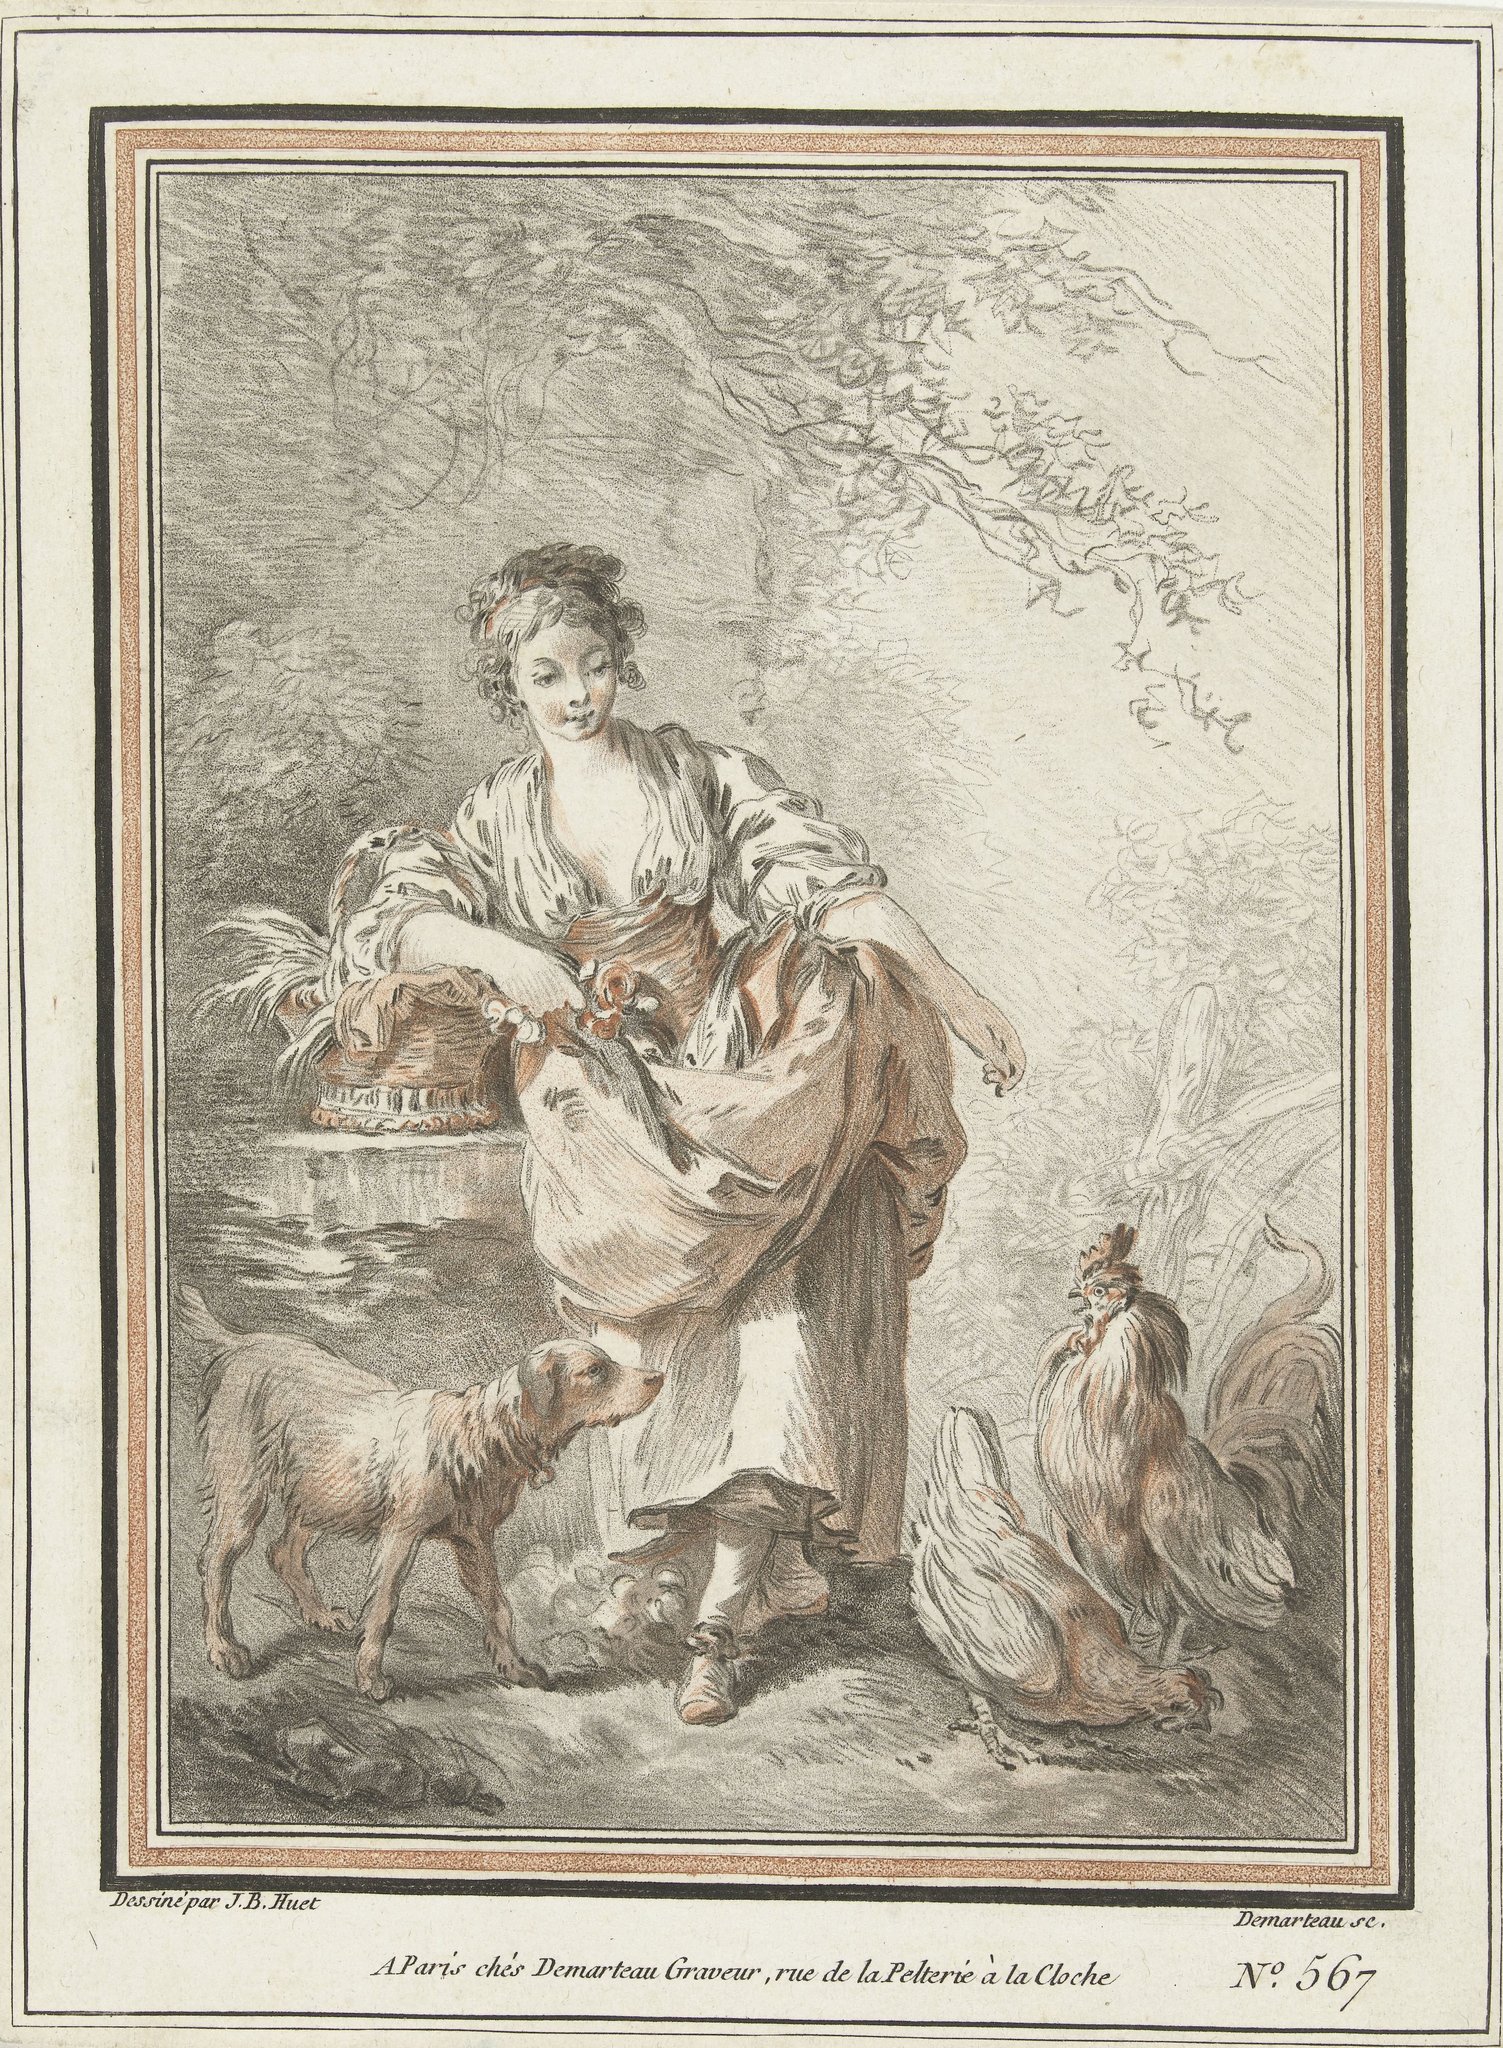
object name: print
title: Jonge vrouw met hond en haan en hen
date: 1732-1776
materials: paper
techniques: printmaking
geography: paris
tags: adolescent, young woman, maiden, fowl (cock, hen, chicken, etc.), dog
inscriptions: collector's mark: Lugt 2228, collector's mark: Lugt 2760